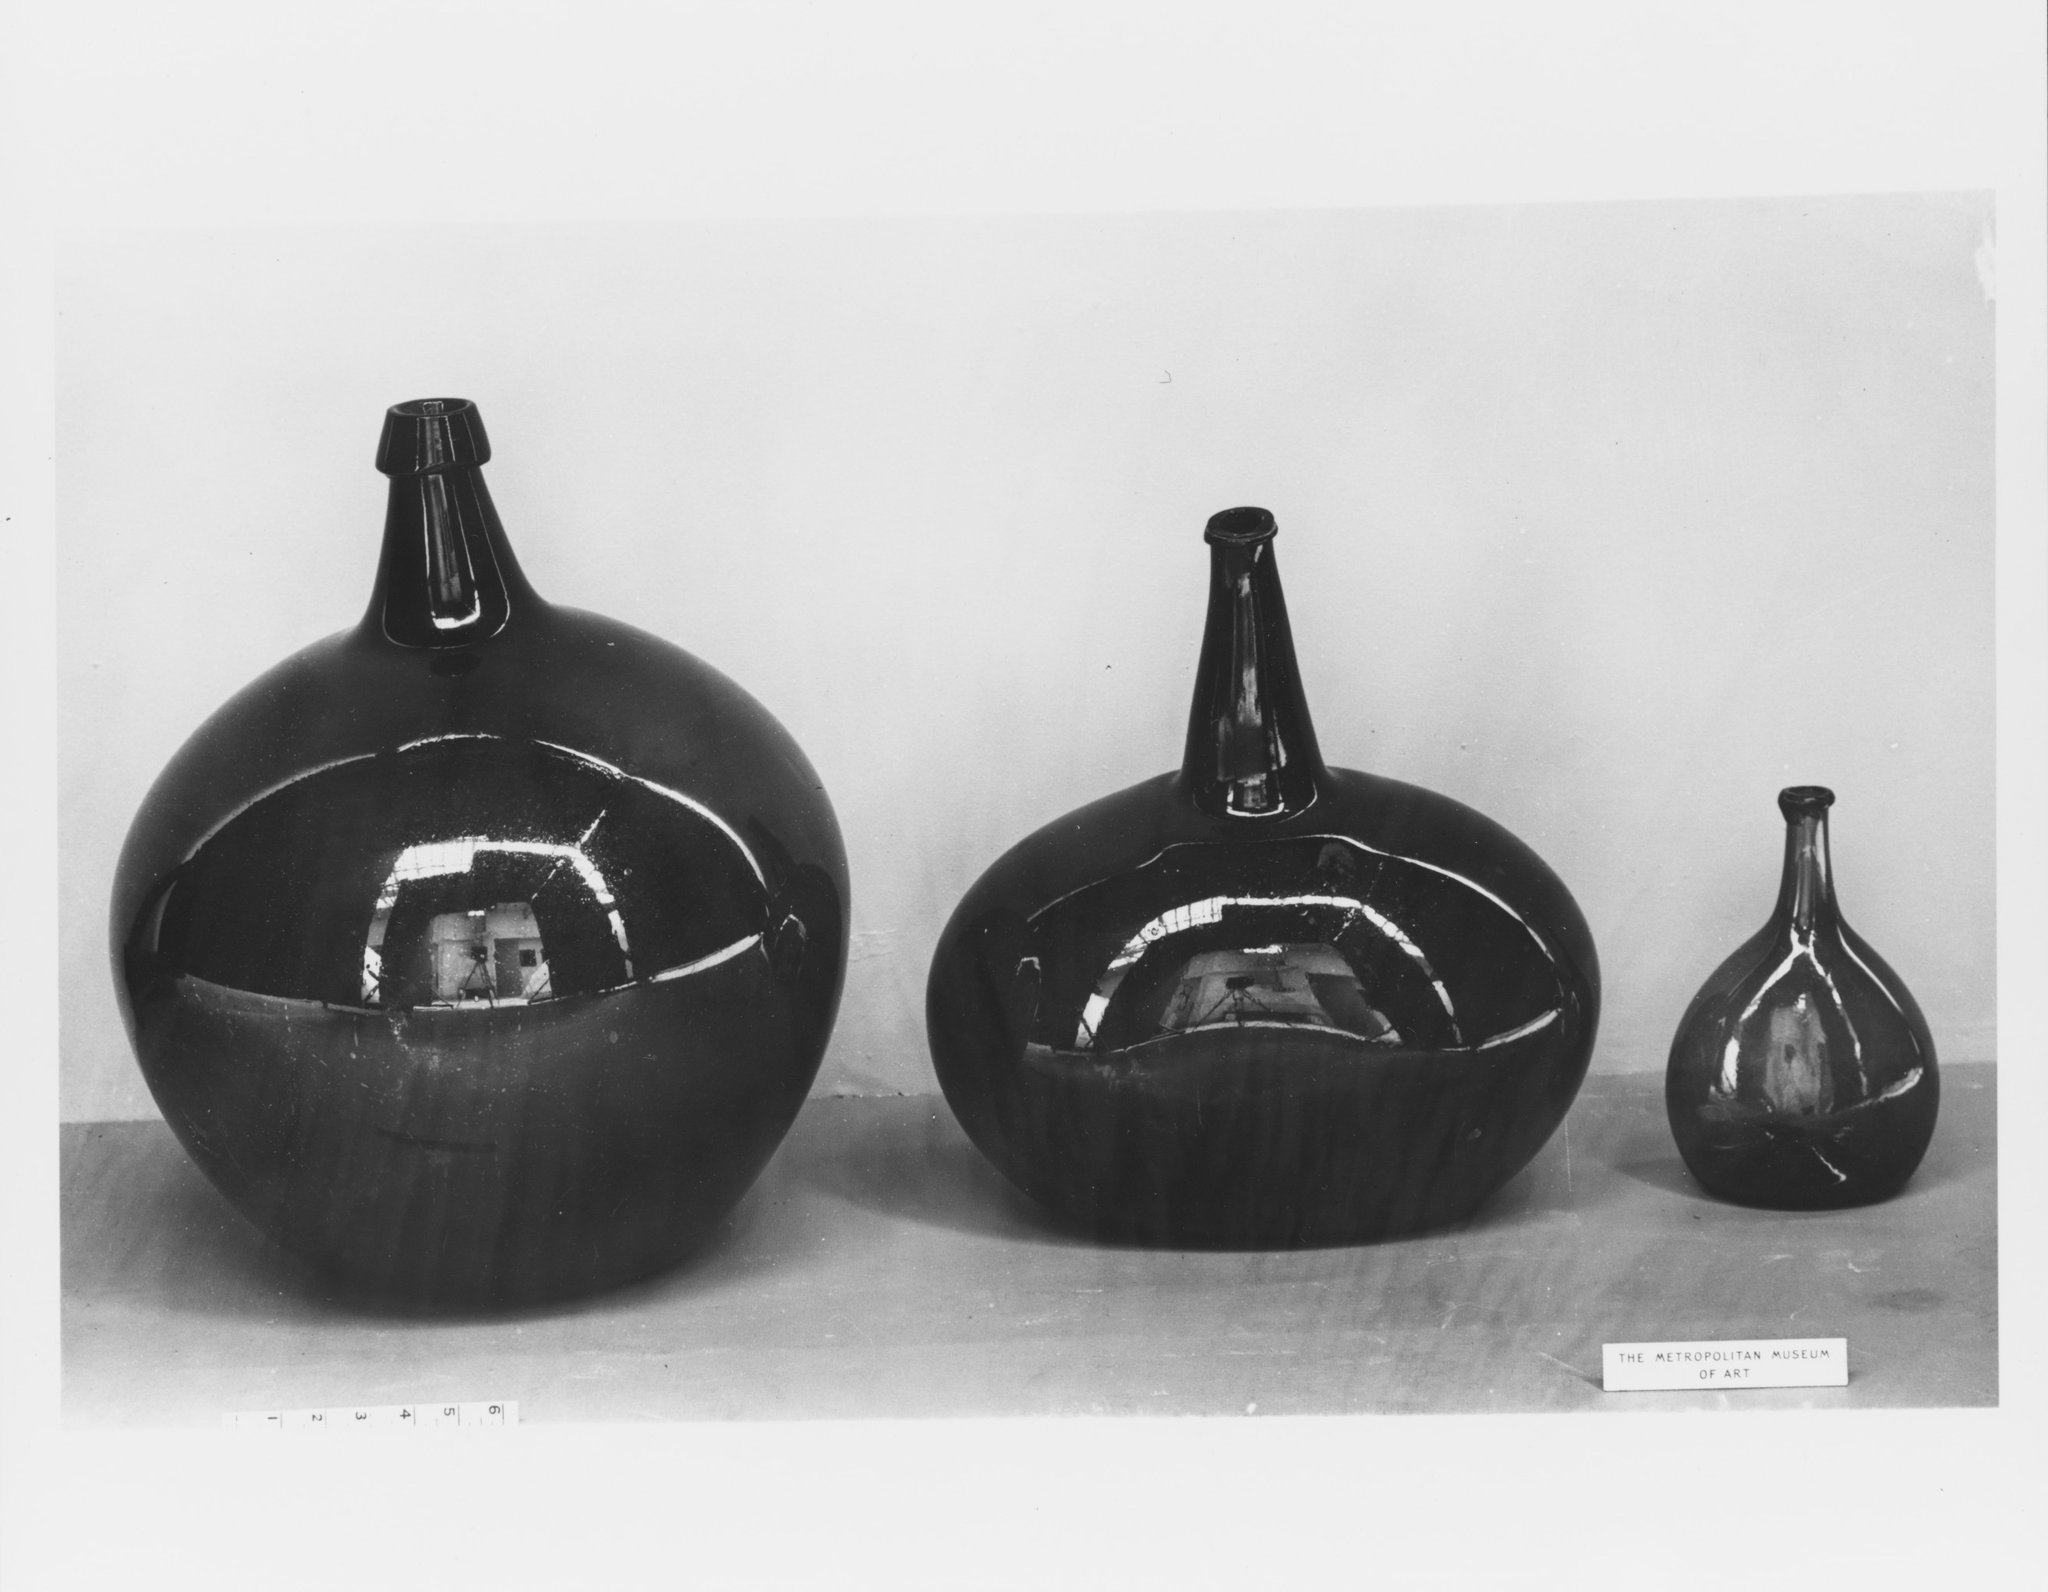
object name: bottle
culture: american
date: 1800-1900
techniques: glassblowing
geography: united states